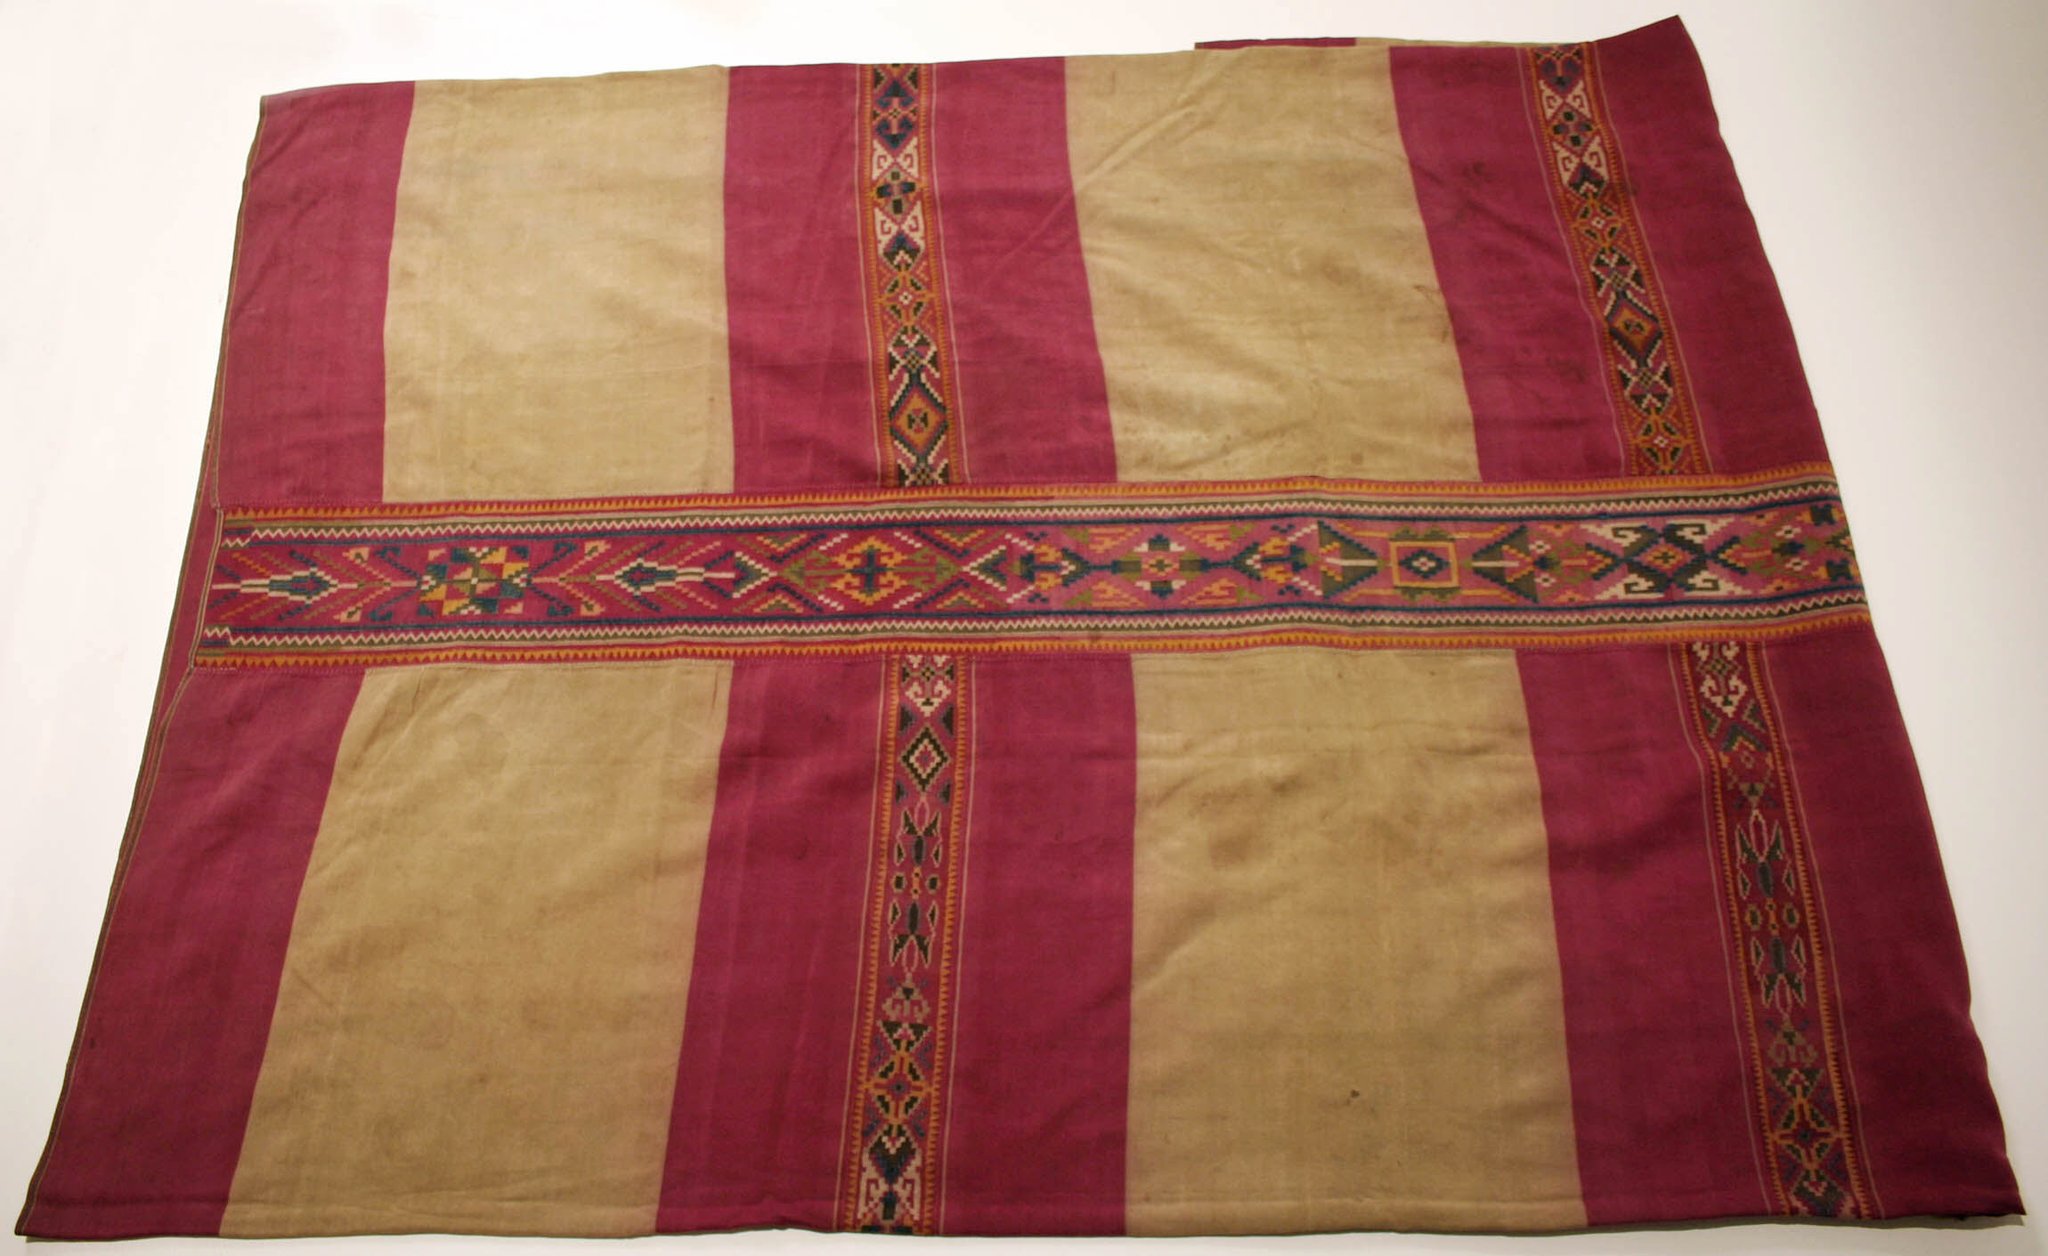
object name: dress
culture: filipino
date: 1801-1833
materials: silk